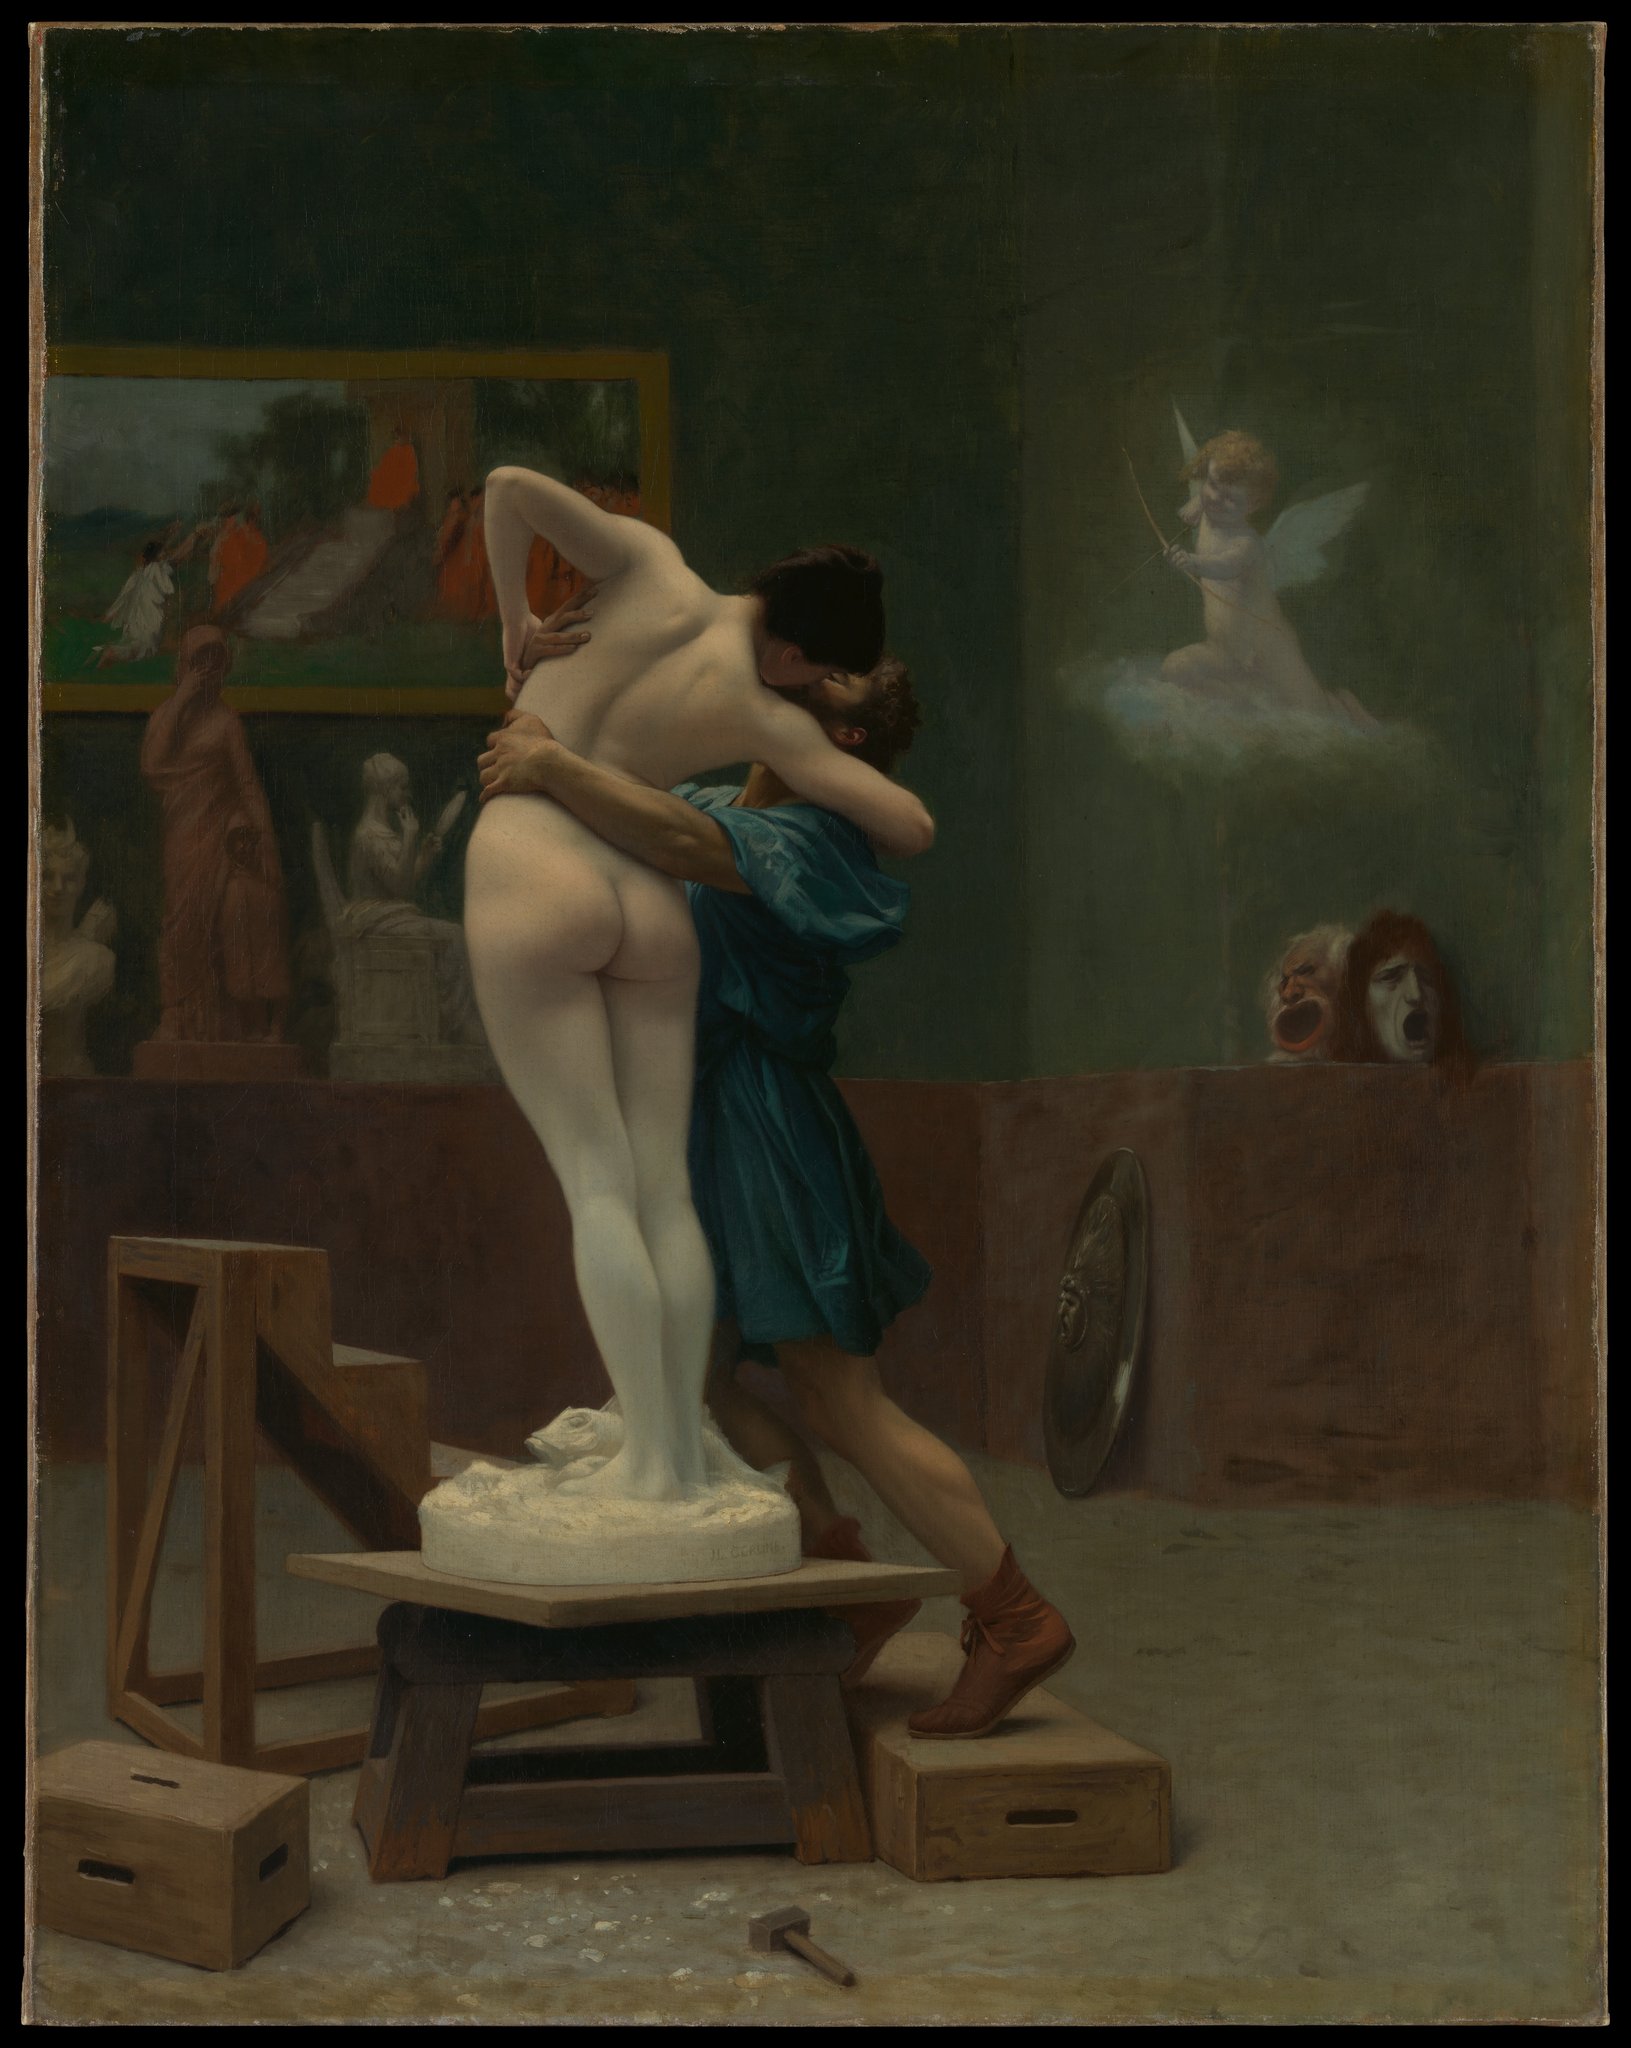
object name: painting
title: Pygmalion and Galatea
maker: jean-léon gérôme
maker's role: artist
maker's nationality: french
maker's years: 1824-1904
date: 1890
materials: canvas, oil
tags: men,female nudes,cupid,galatea,pygmalion,artists